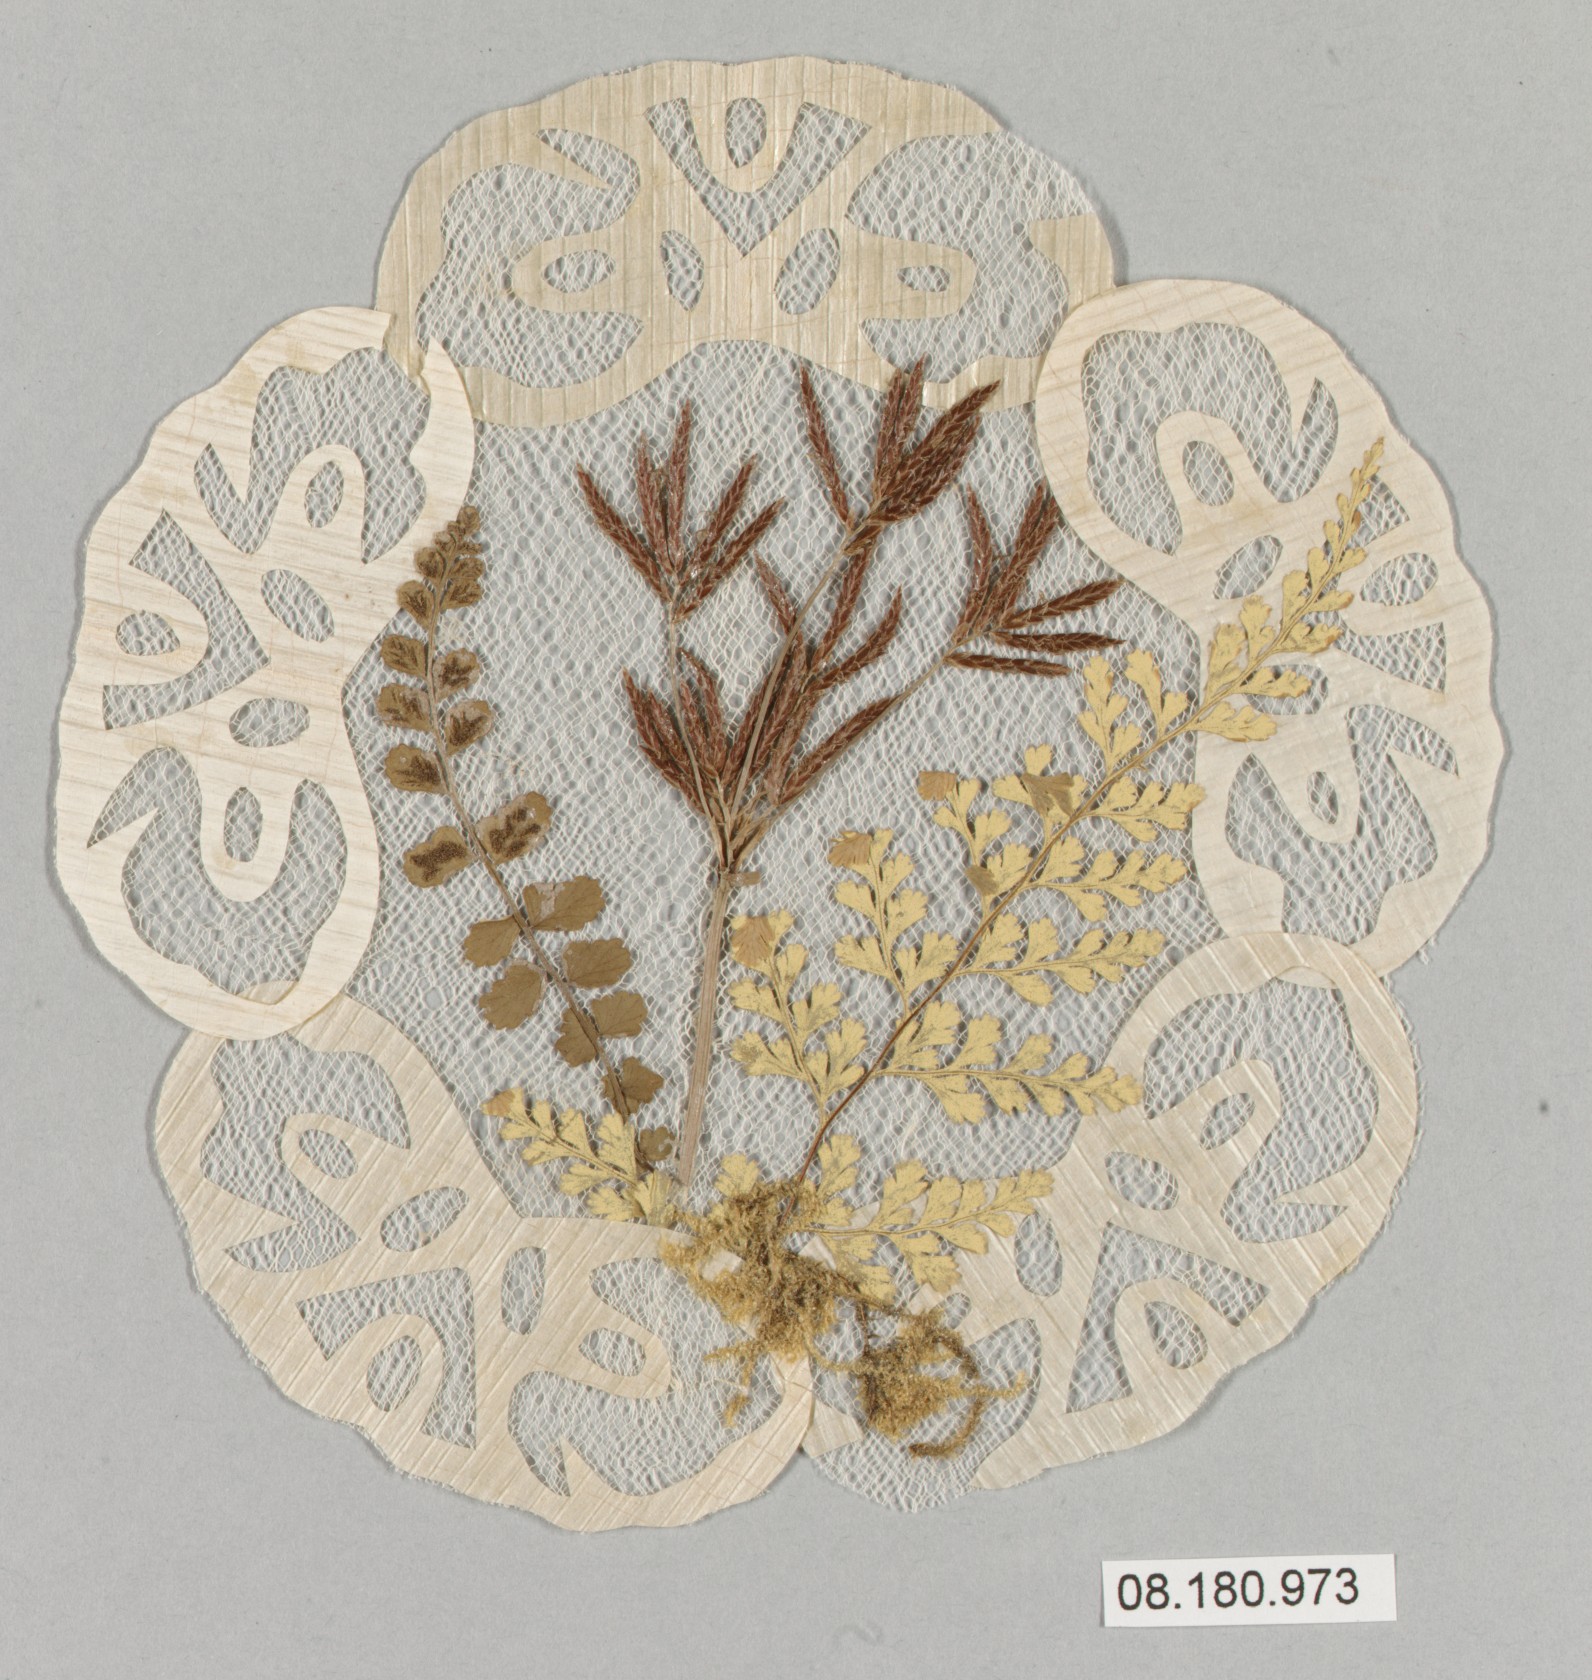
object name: doily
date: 1801-1900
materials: lace